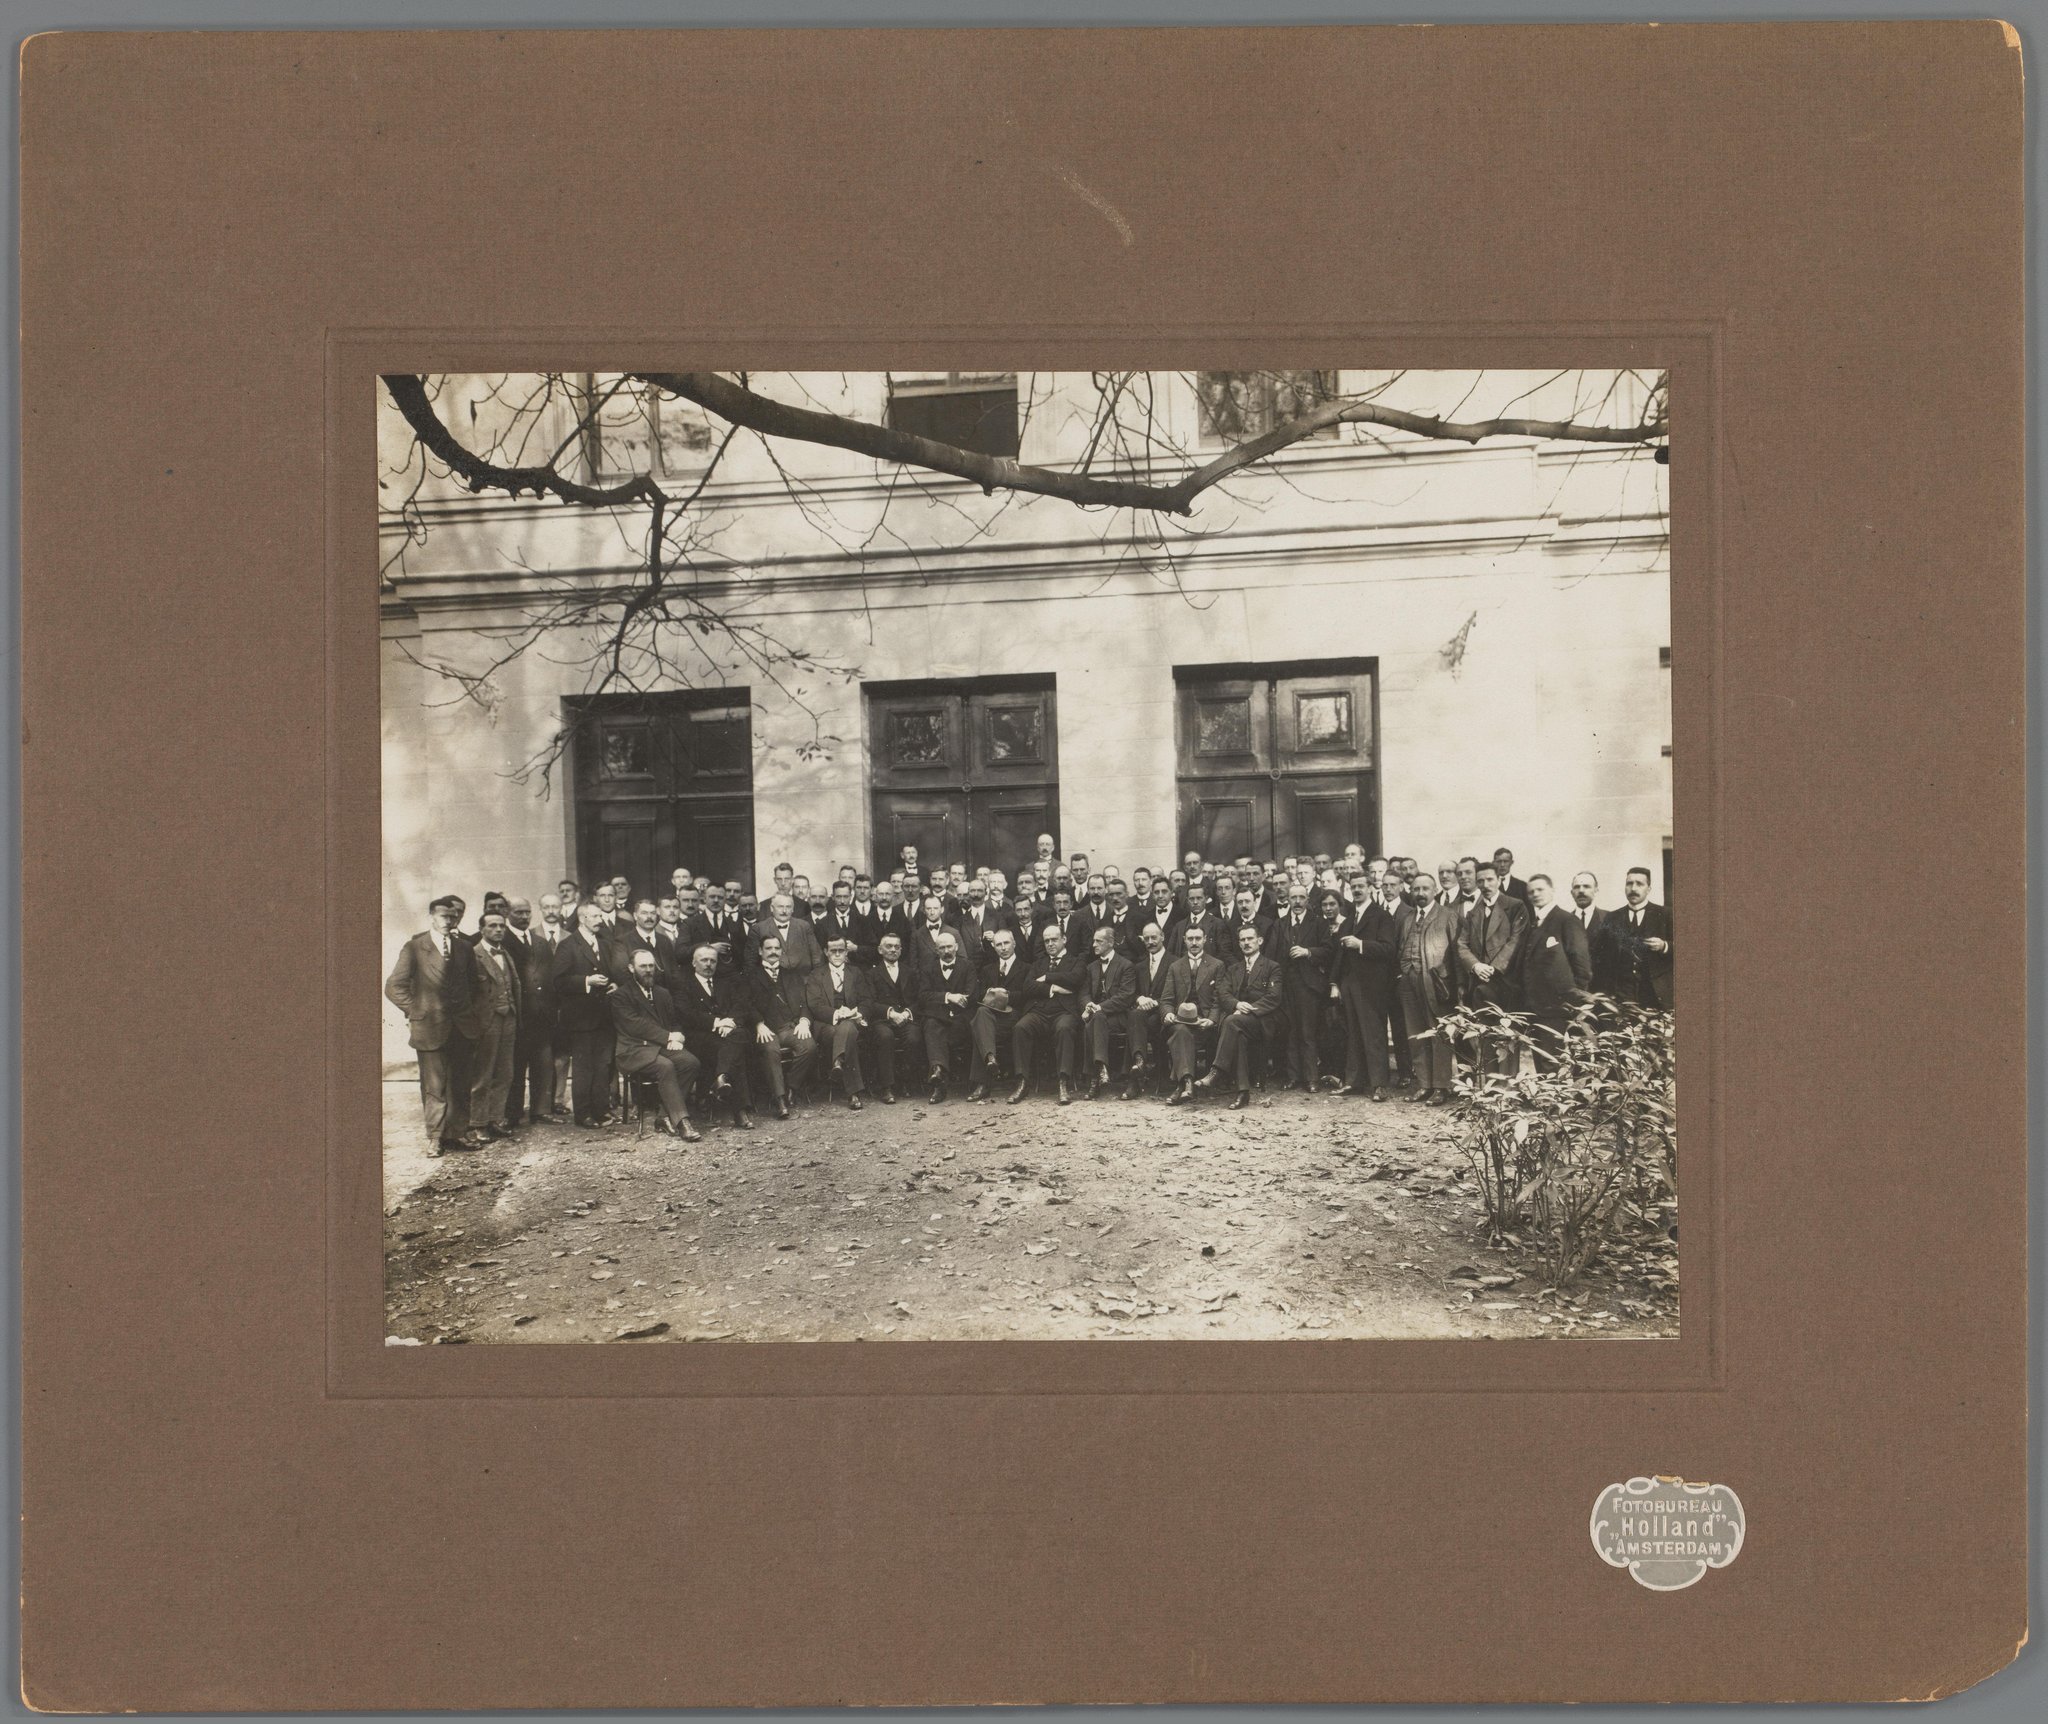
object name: photograph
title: Groepsportret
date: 1930-1940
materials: cardboard, photographic support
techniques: gelatin silver print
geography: netherlands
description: Een groep van bijna honderd heren en een enkele dame, staand en zittend voor een gevel met drie grote ramen.